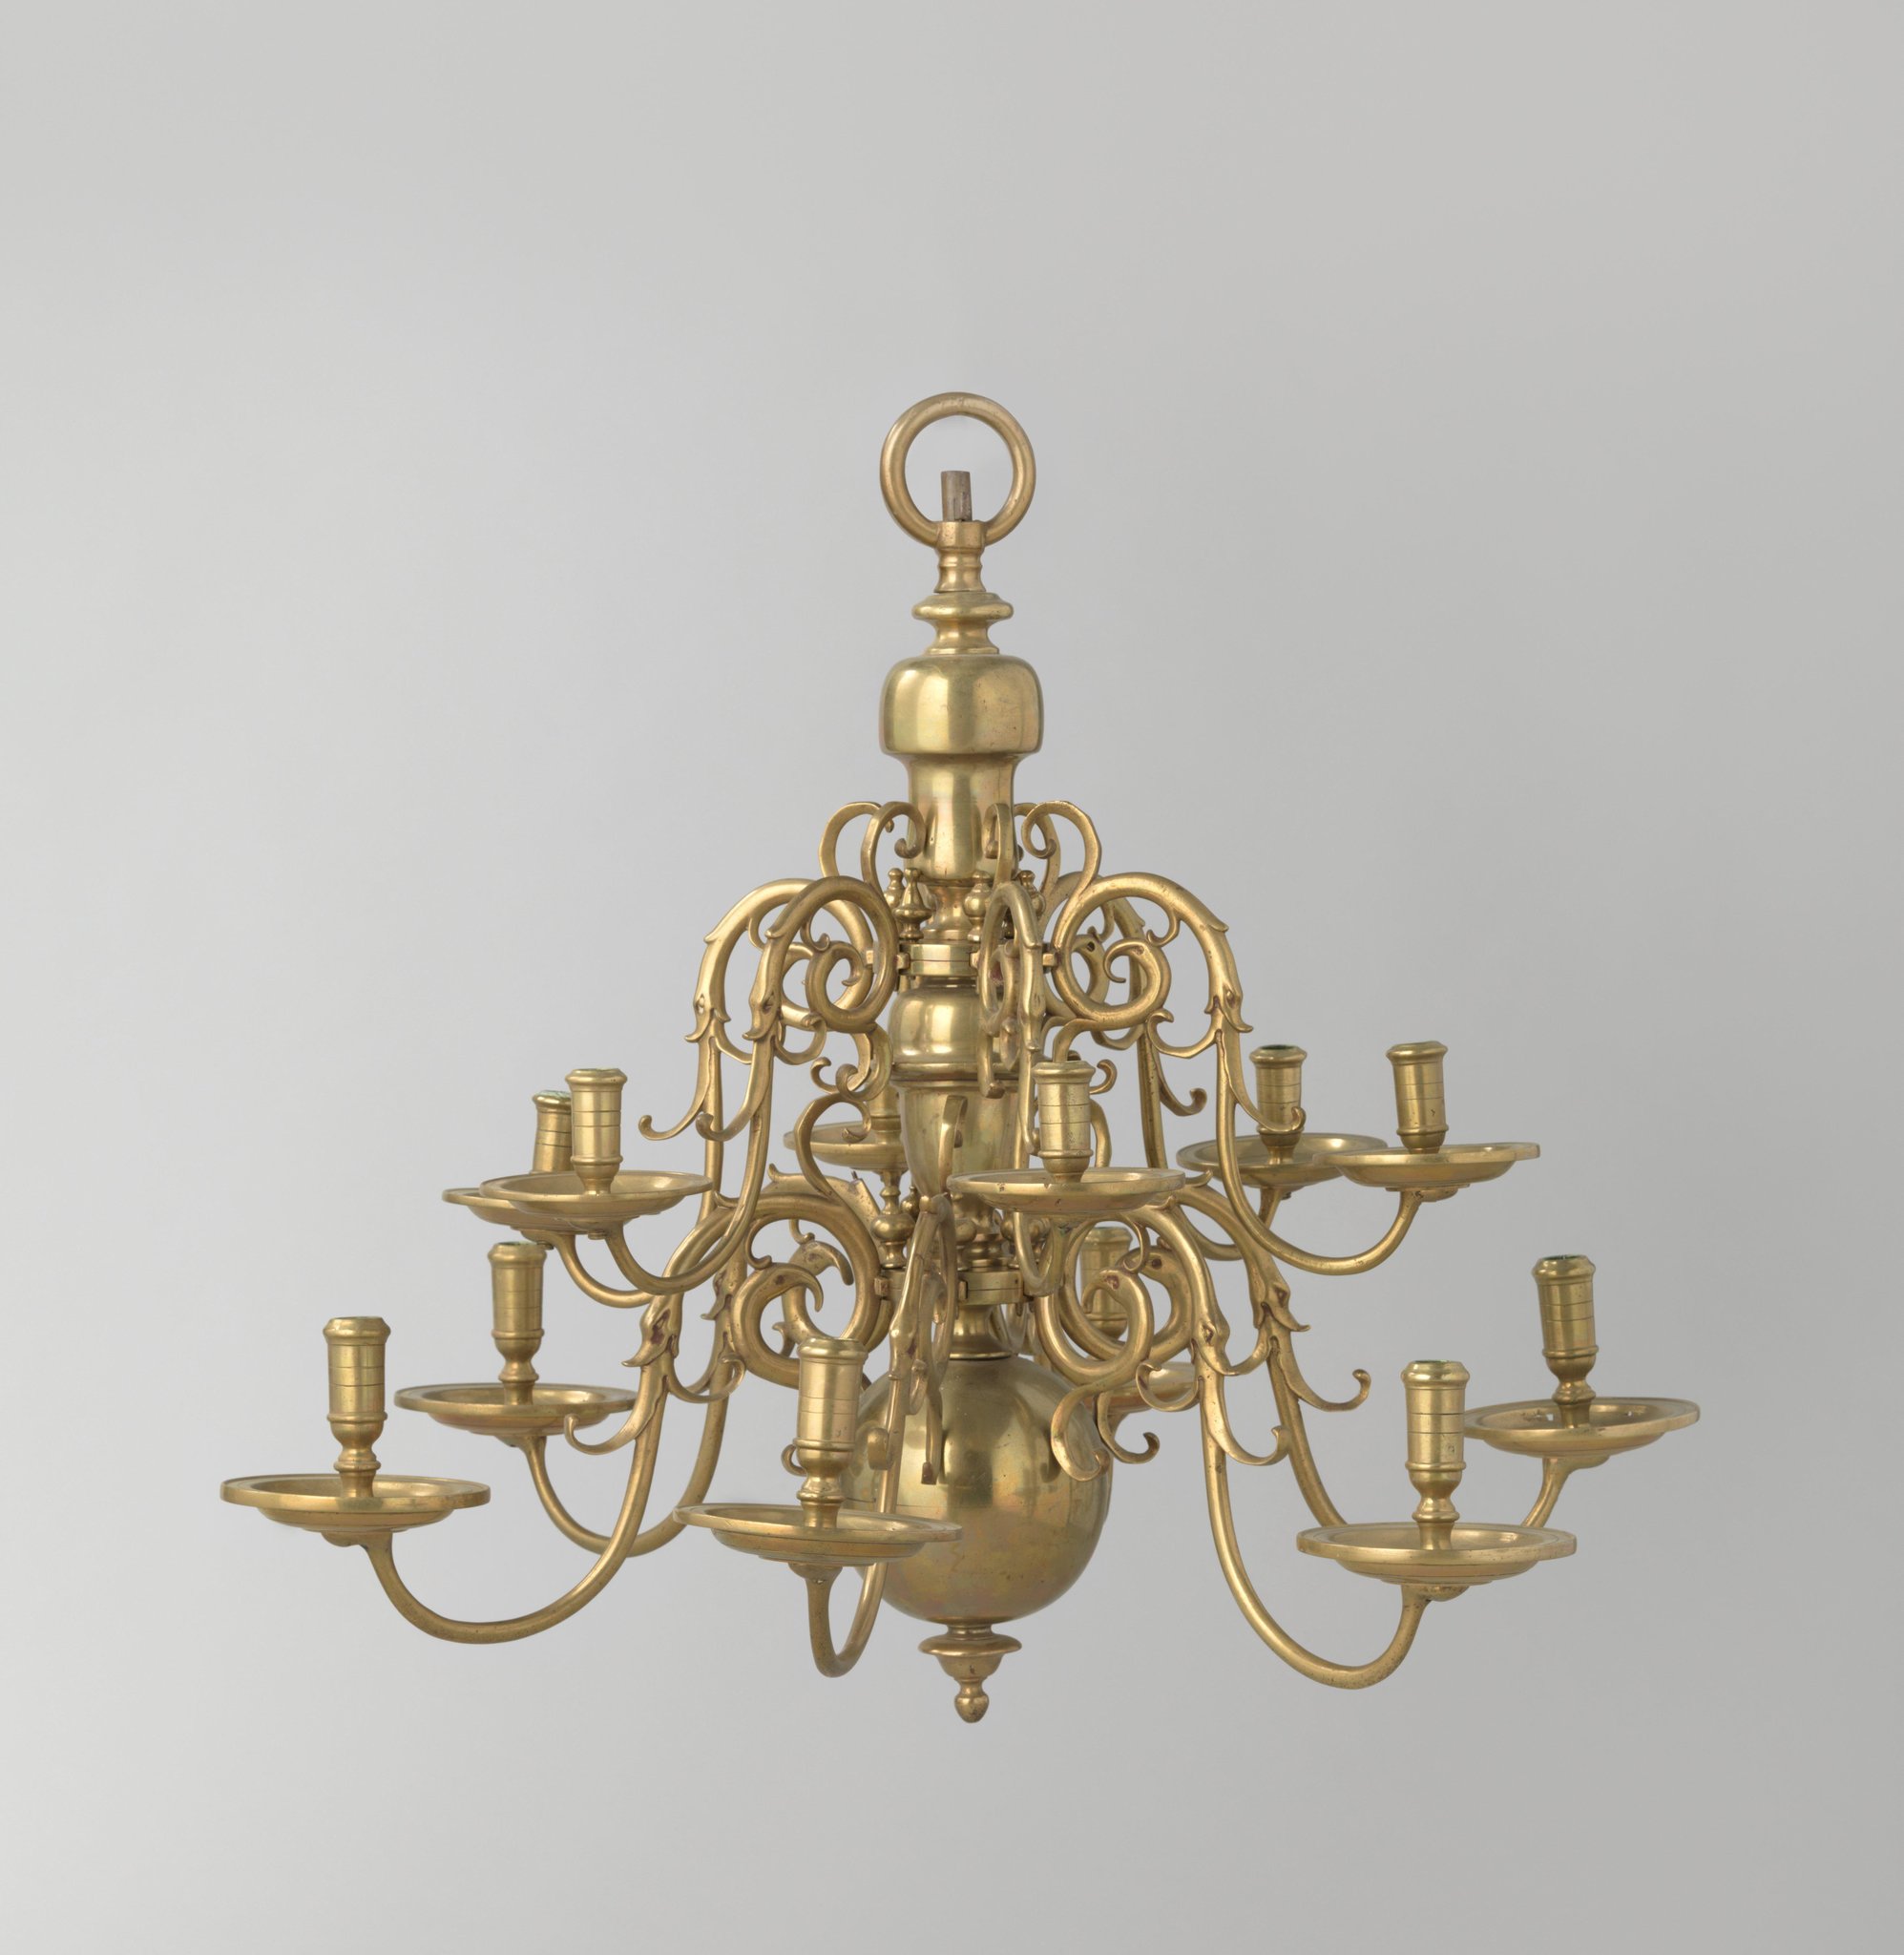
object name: chandelier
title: Arm met kaarsenhouder van kaarsenkroon van twee hoogten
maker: Anonymous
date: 1800-1875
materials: brass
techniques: casting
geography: netherlands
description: Kaarsenarm behorende bij een messing kaarsenkroon van twee hoogten. De S-vormige arm heeft een krul bij de aanzet, halverwege een dolfijnenkop en gaat naar buiten toe over in het platte verdikking met een schroefgat. Daarin is de kaarsenhouder met de vetvanger vastgezet. De vetvanger is aan de onderzijde geribd geprofileerd rond de opening en heeft een naar onder en naar boven toe iets uitstekend randje en is versierd met gegroefde forse ringen. De cylindrische kaarsenhouder heeft een geprofileerde en een weinig uitstekende rand, twee gegroefde ringen, een rib en een geprofileerd holrond onderstuk, dat overgaat in een uitsteeksel met een schroefdraad met een centergat. Dit is de vierde arm van de bovenste standring, genummerd met 4 ronde punten.